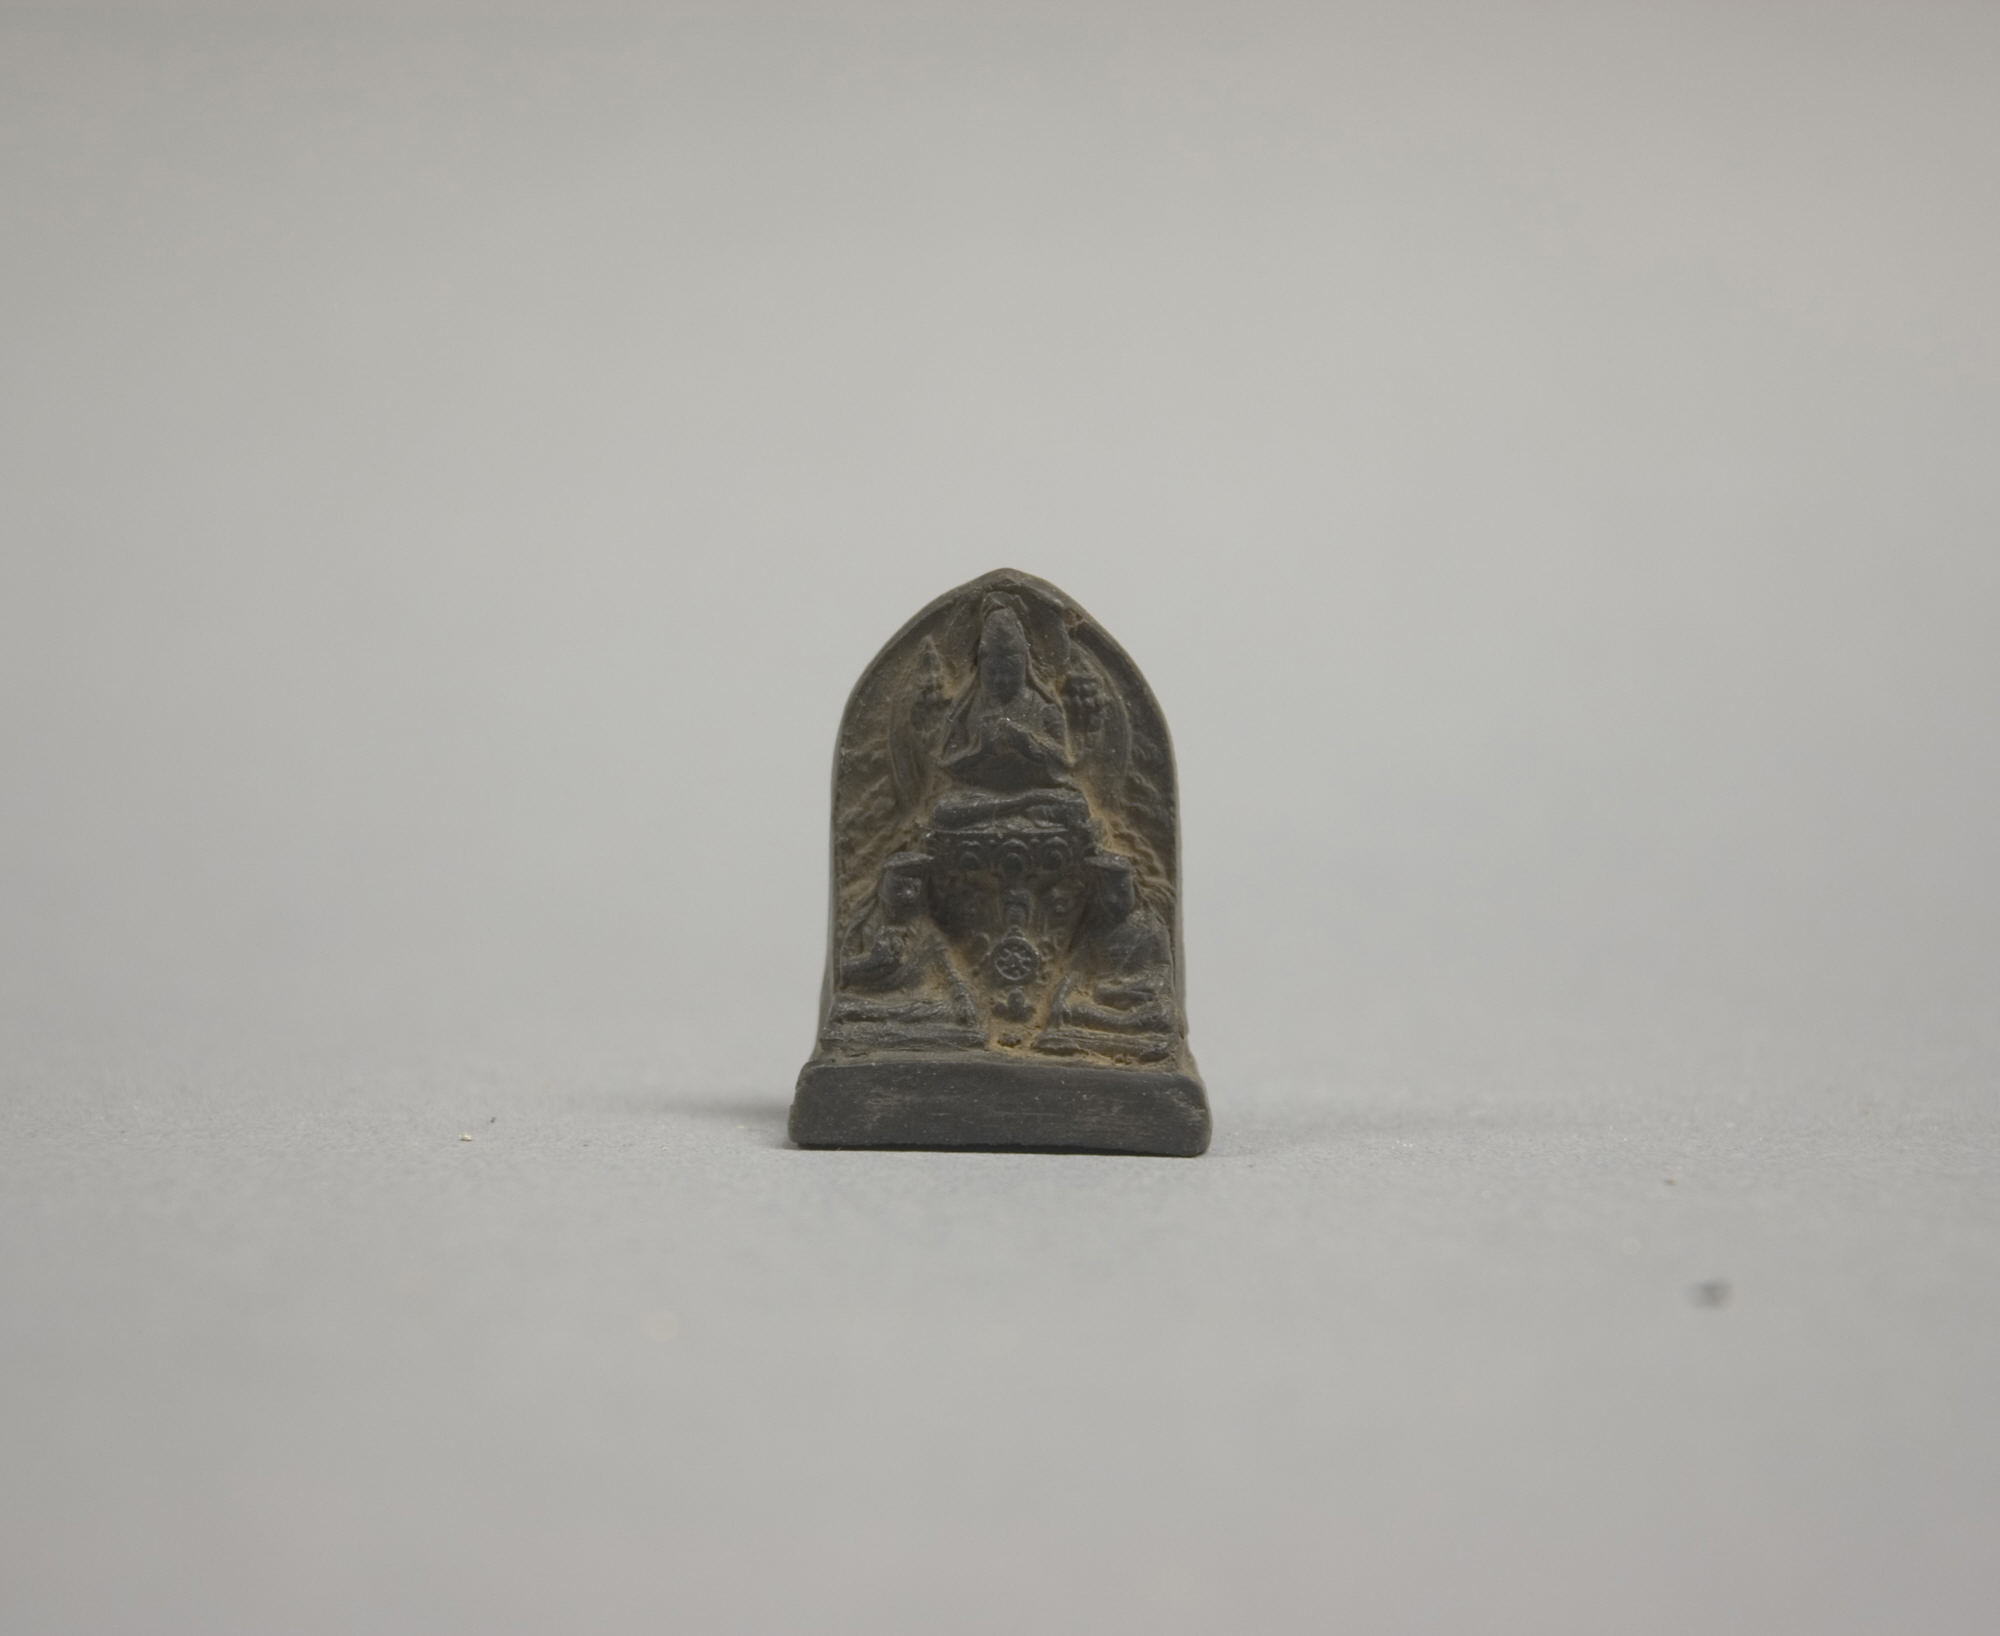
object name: votive plaque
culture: tibetan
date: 701-800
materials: clay